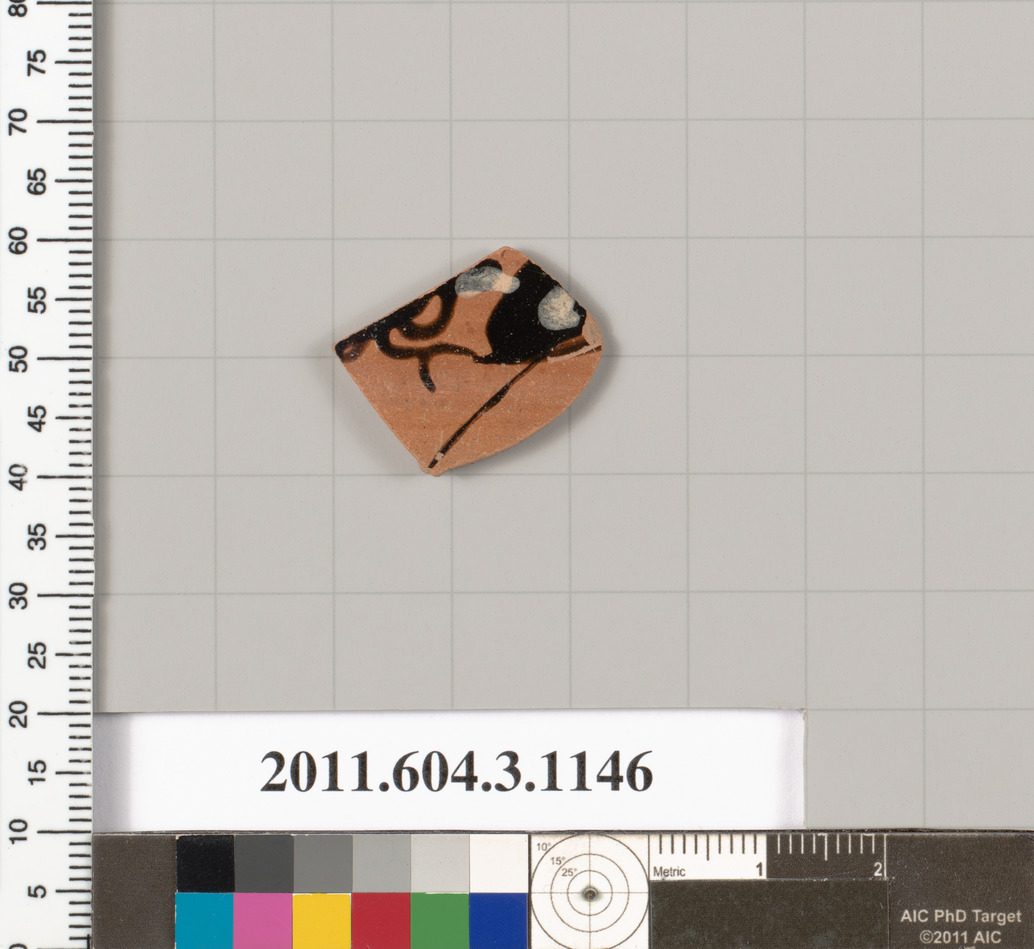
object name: mastoid or kyathos fragment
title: Terracotta fragment of a mastoid (drinking cup with narrow base) or a kyathos (cup-shaped ladle)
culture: greek, attic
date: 534-468 BCE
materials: terracotta